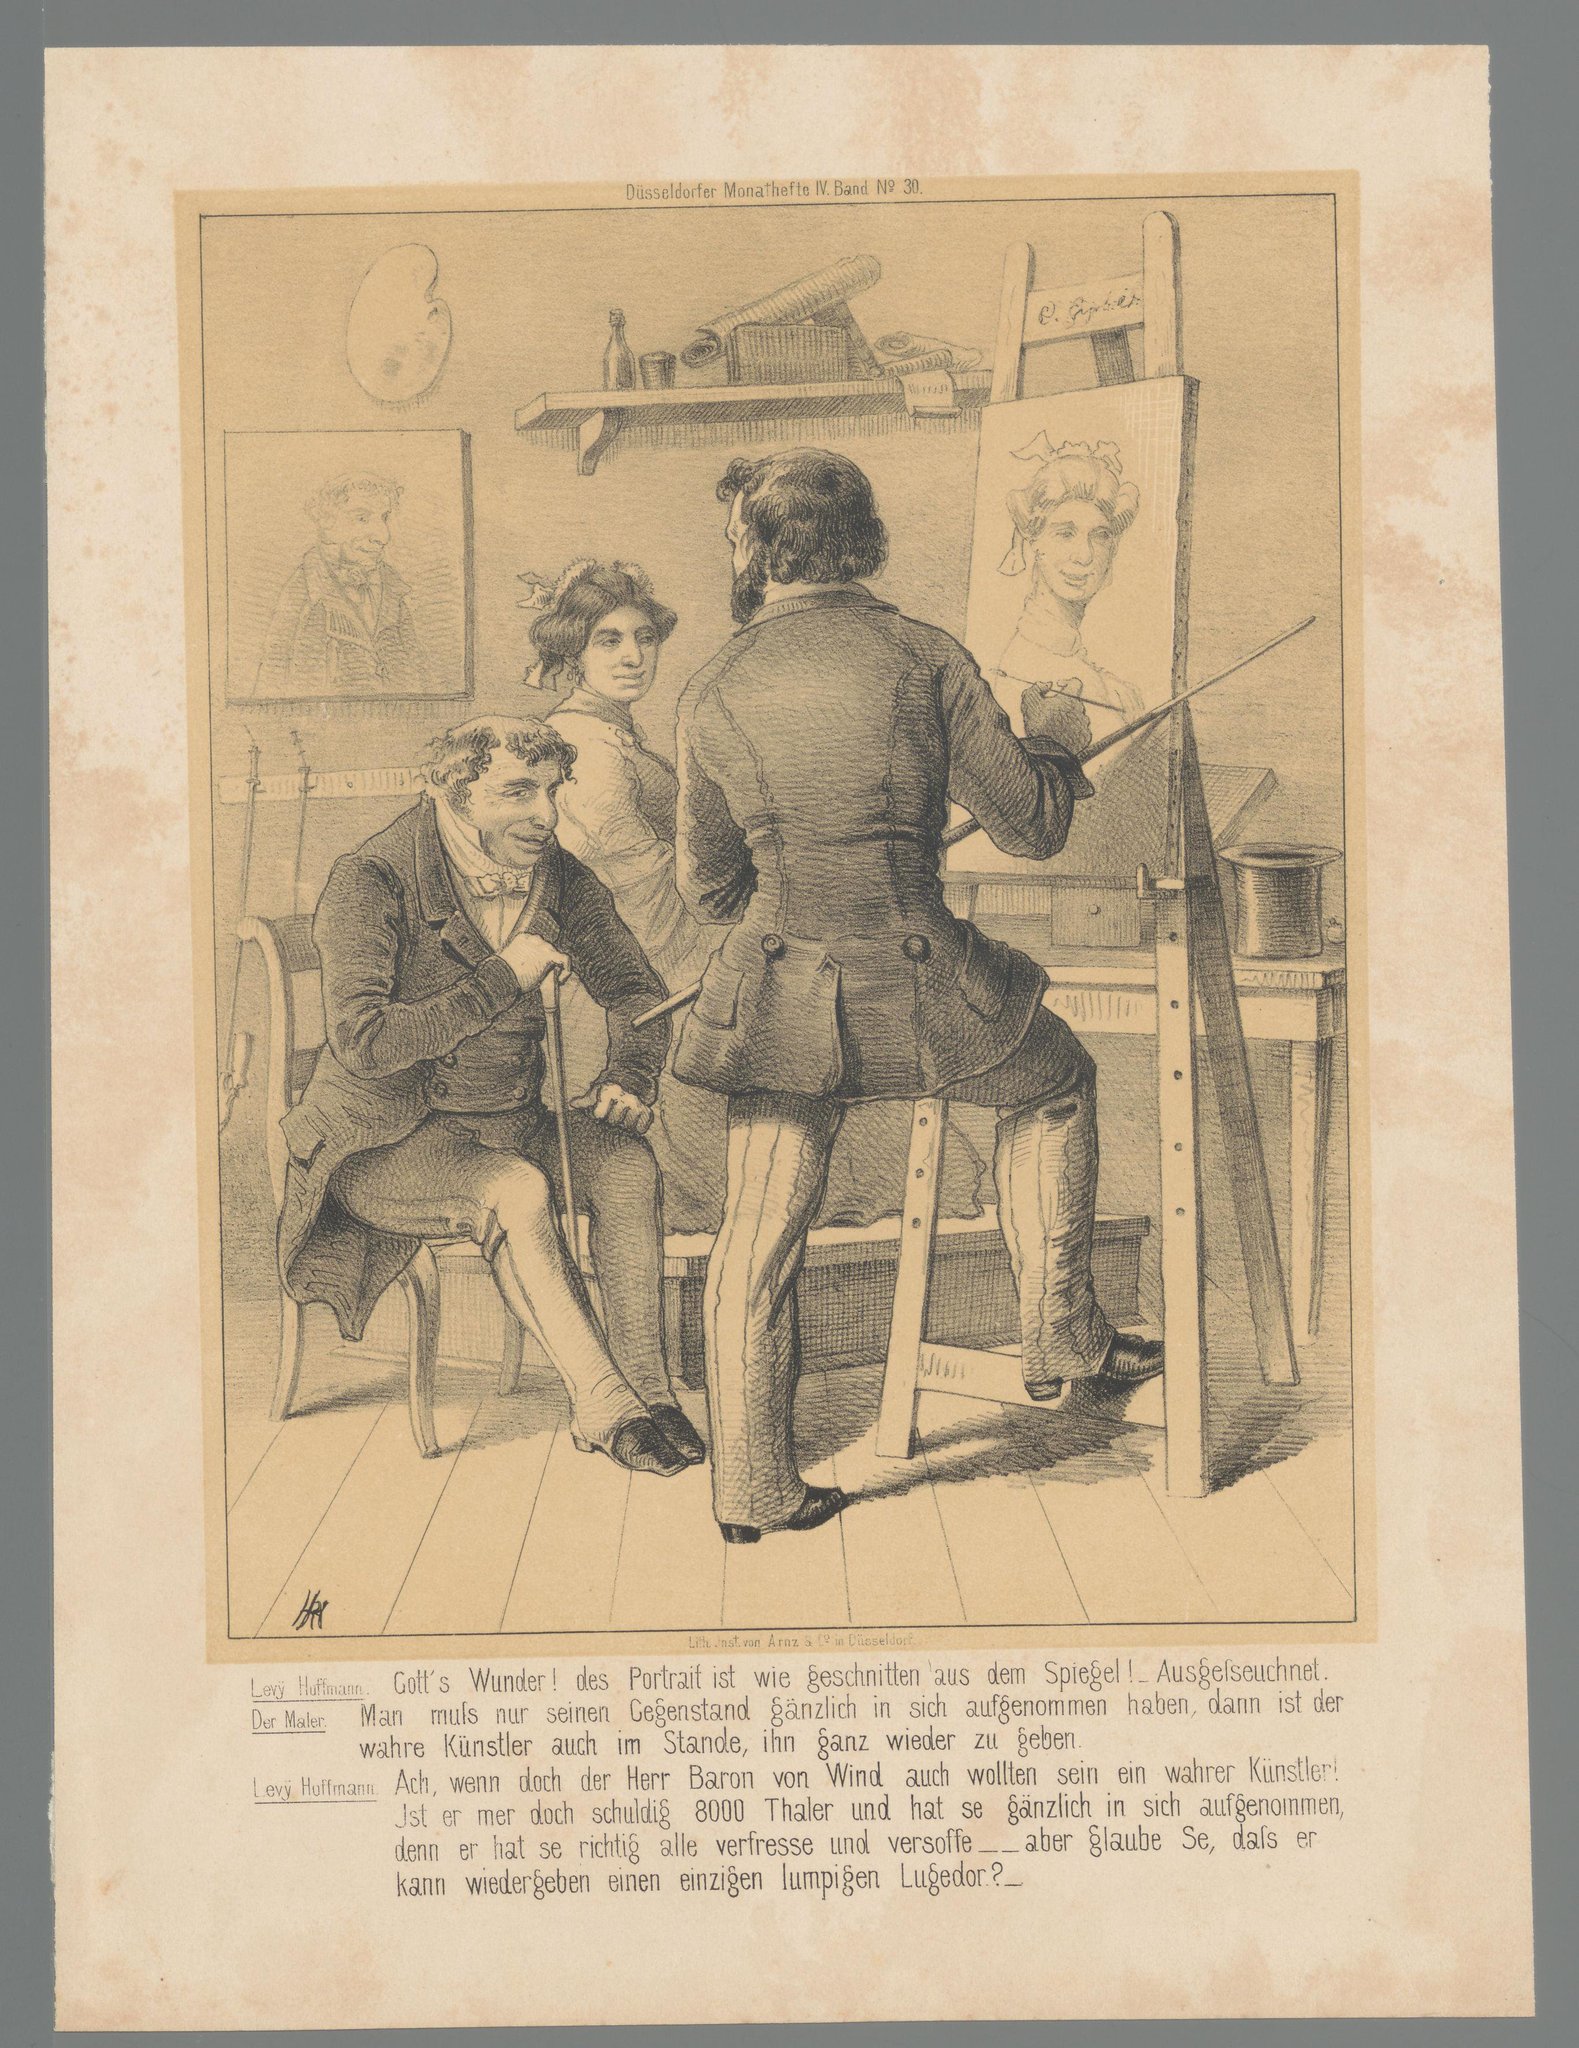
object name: print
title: Schilder portretteert een man en vrouw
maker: monogrammist hr (duitsland)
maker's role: print maker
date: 1851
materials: paper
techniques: tone lithography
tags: model, sitter ~ painting, easel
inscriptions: collector's mark: Lugt 2228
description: Prent uit: Düsseldorfer Monathefte 4 (1851), afb. 30.